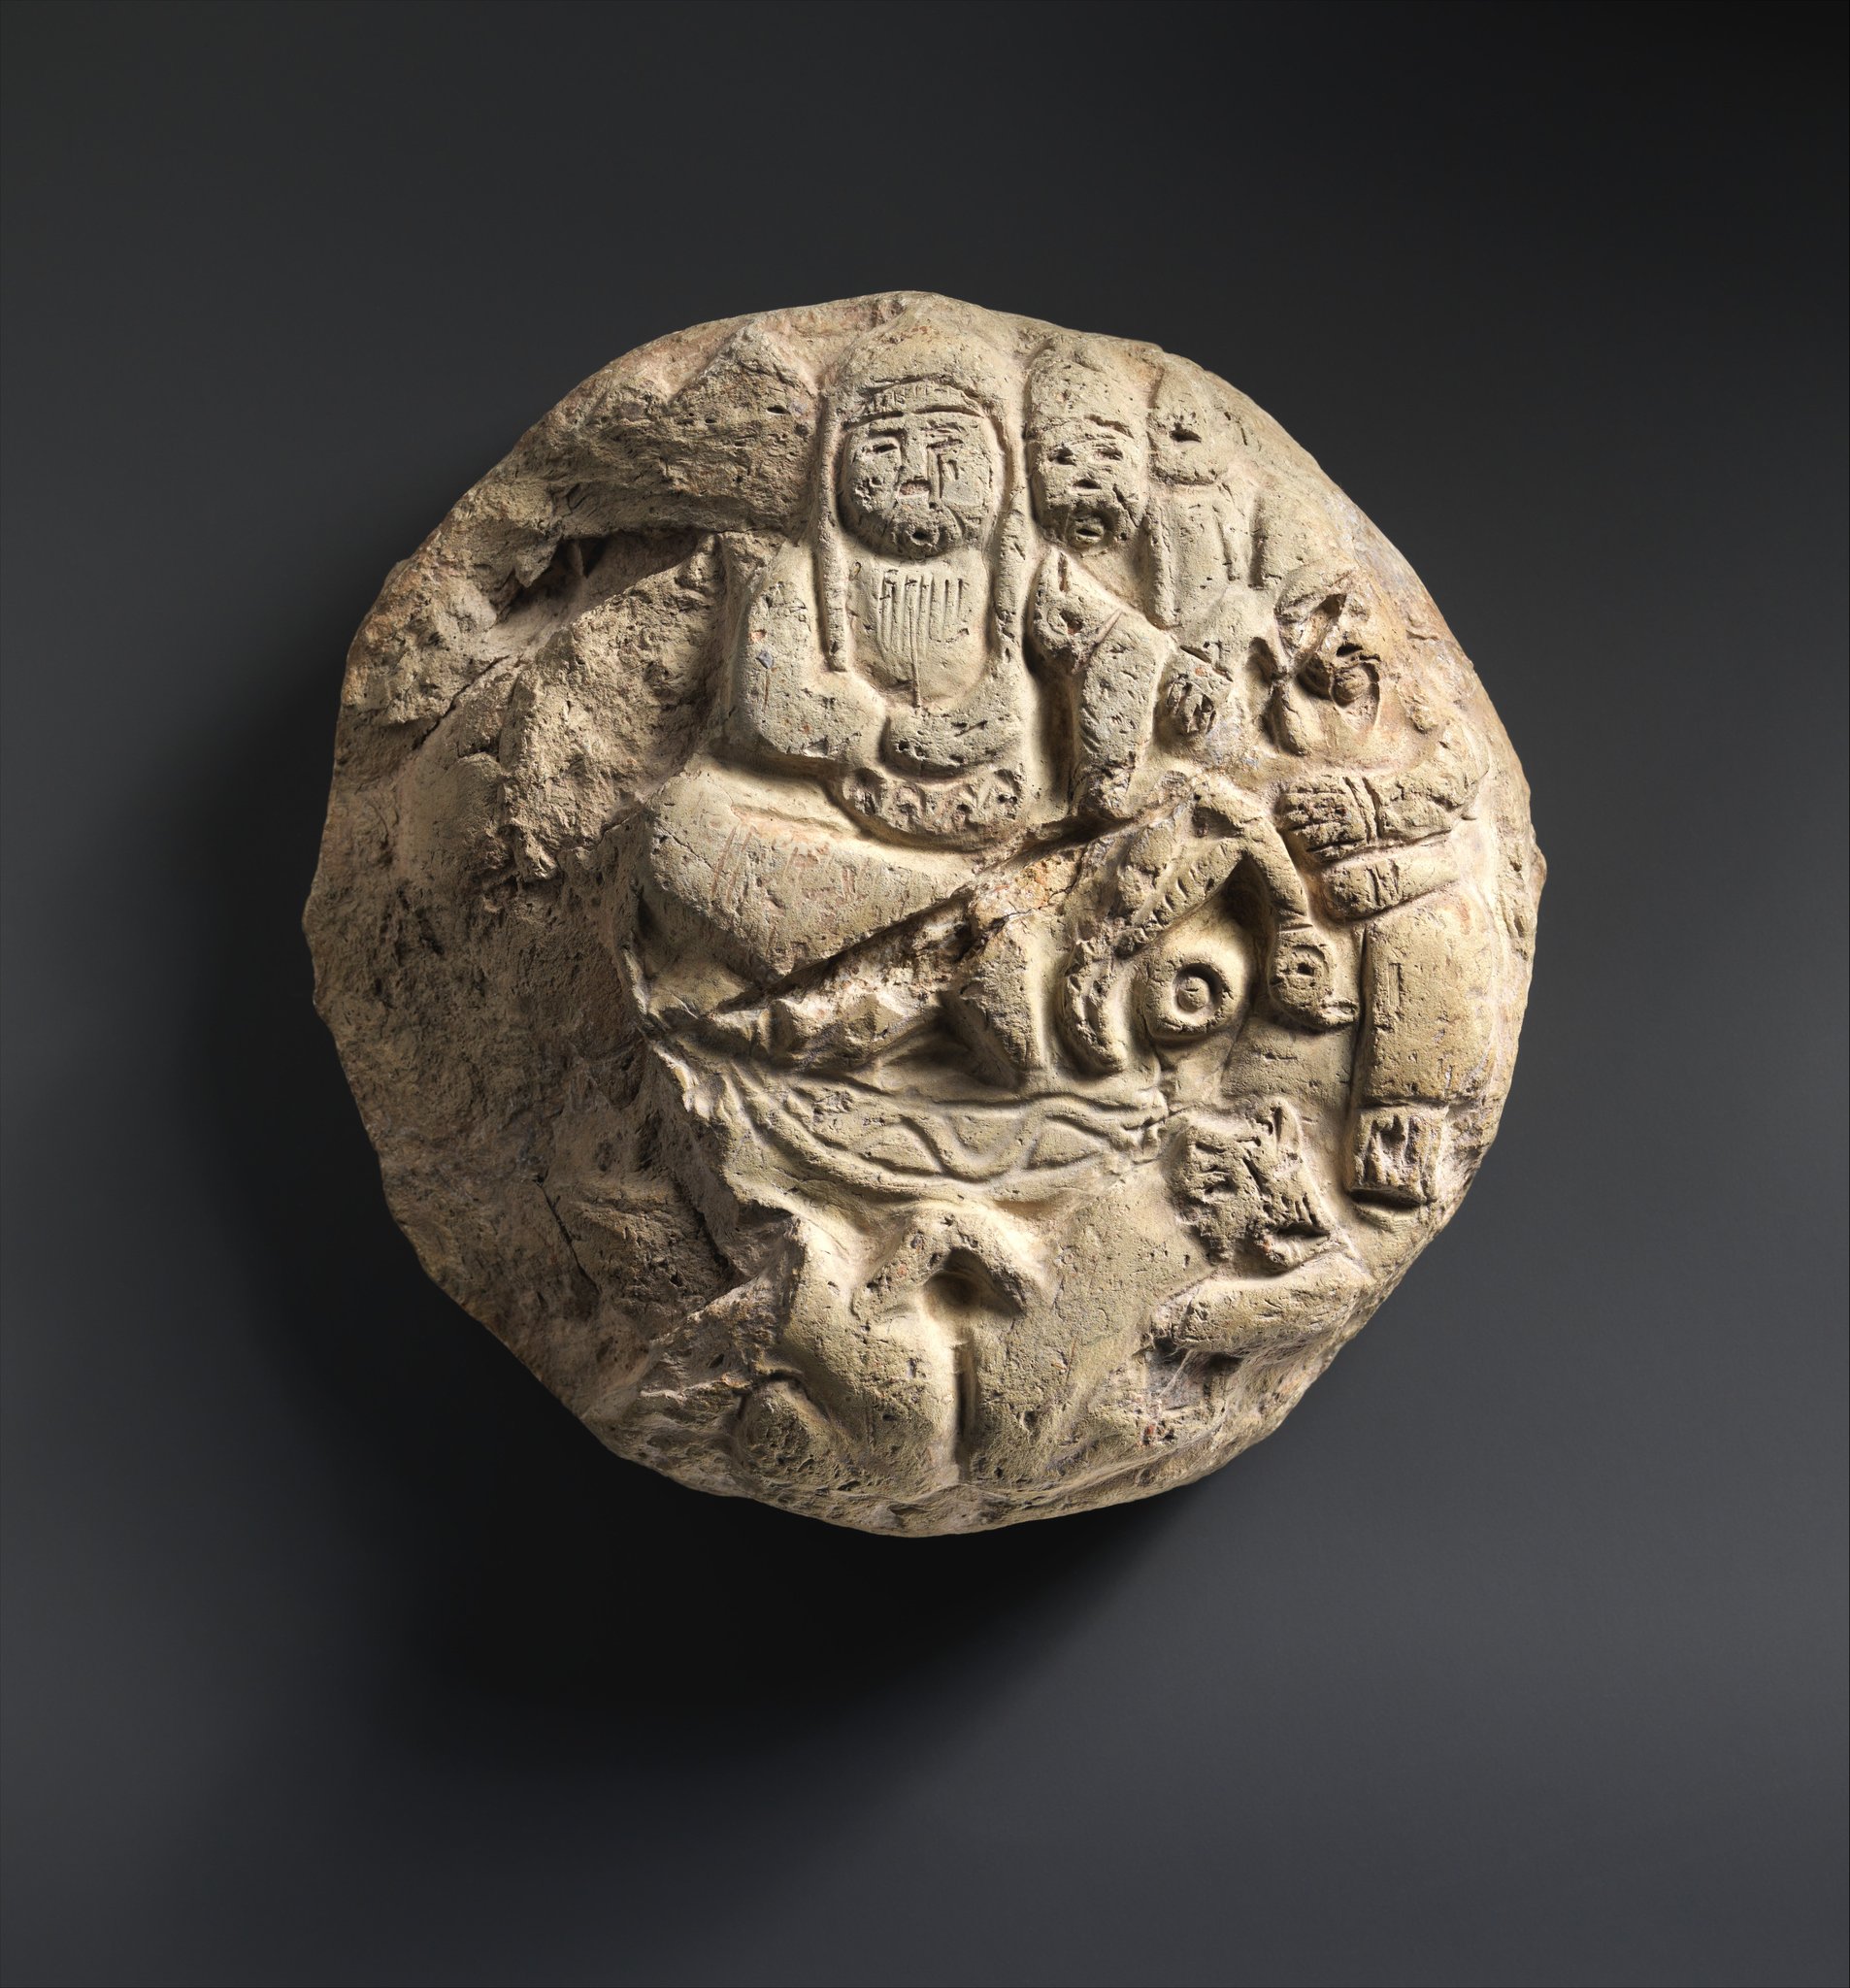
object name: medallion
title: Medallion with Enthroned Figure and Attendants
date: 1101-1300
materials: earthenware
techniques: carving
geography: iran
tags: medallions,men